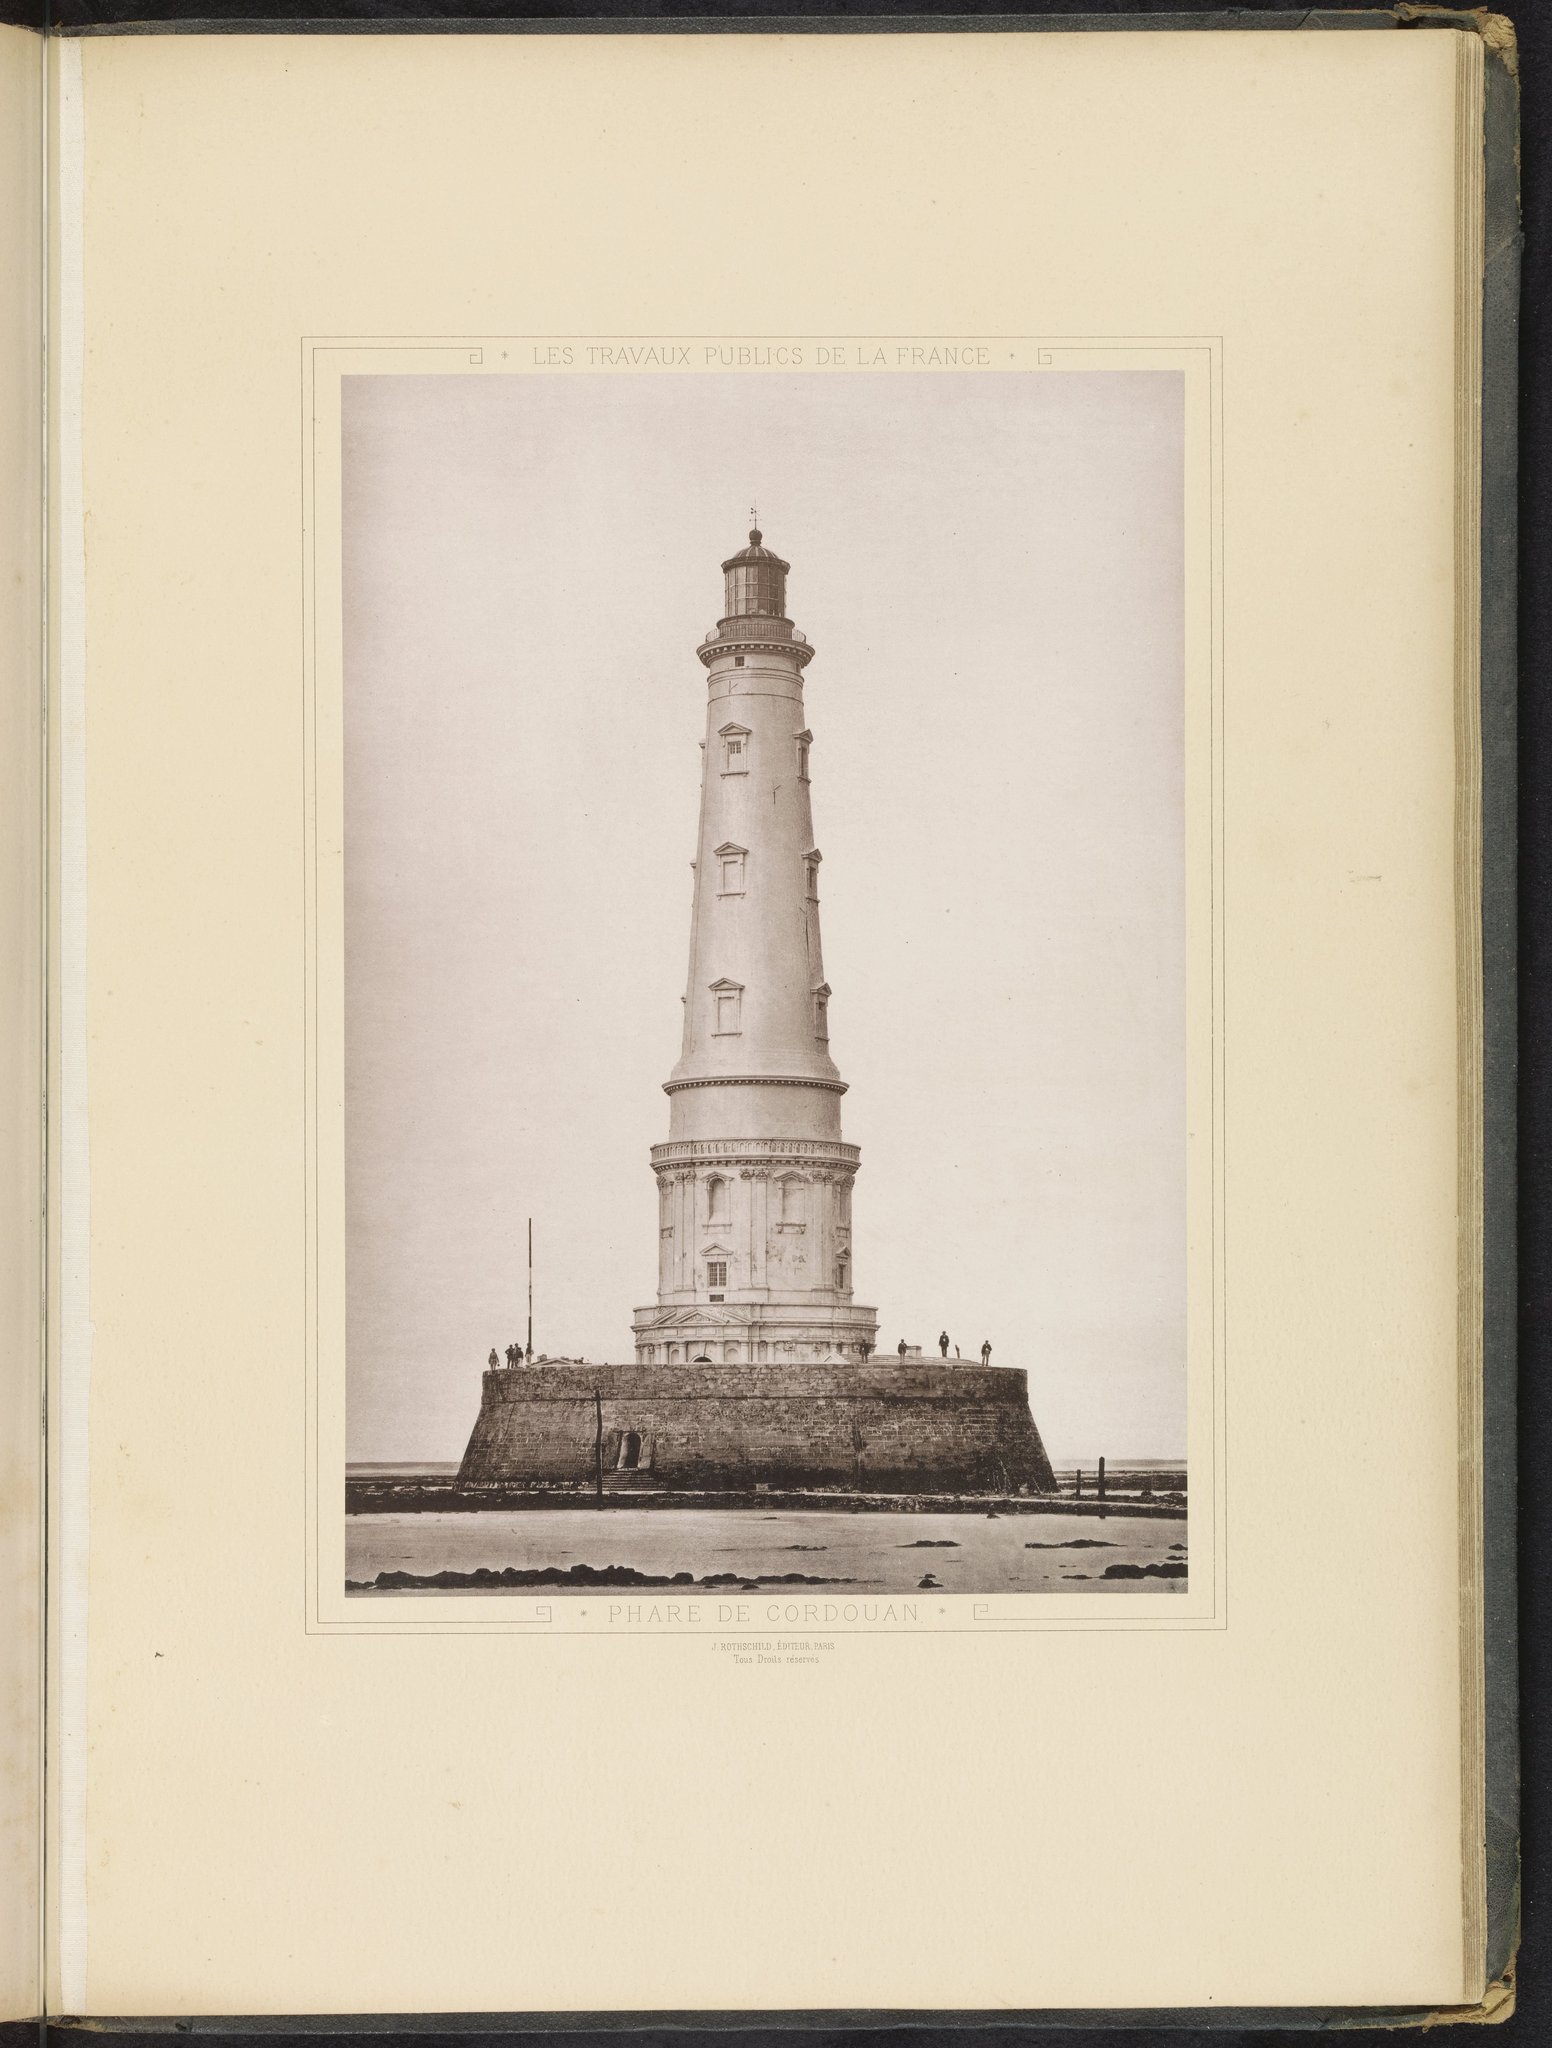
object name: photomechanical print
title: Phare de Cordouan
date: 1873-1883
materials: paper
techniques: photograph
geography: france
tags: lighthouse, lightship